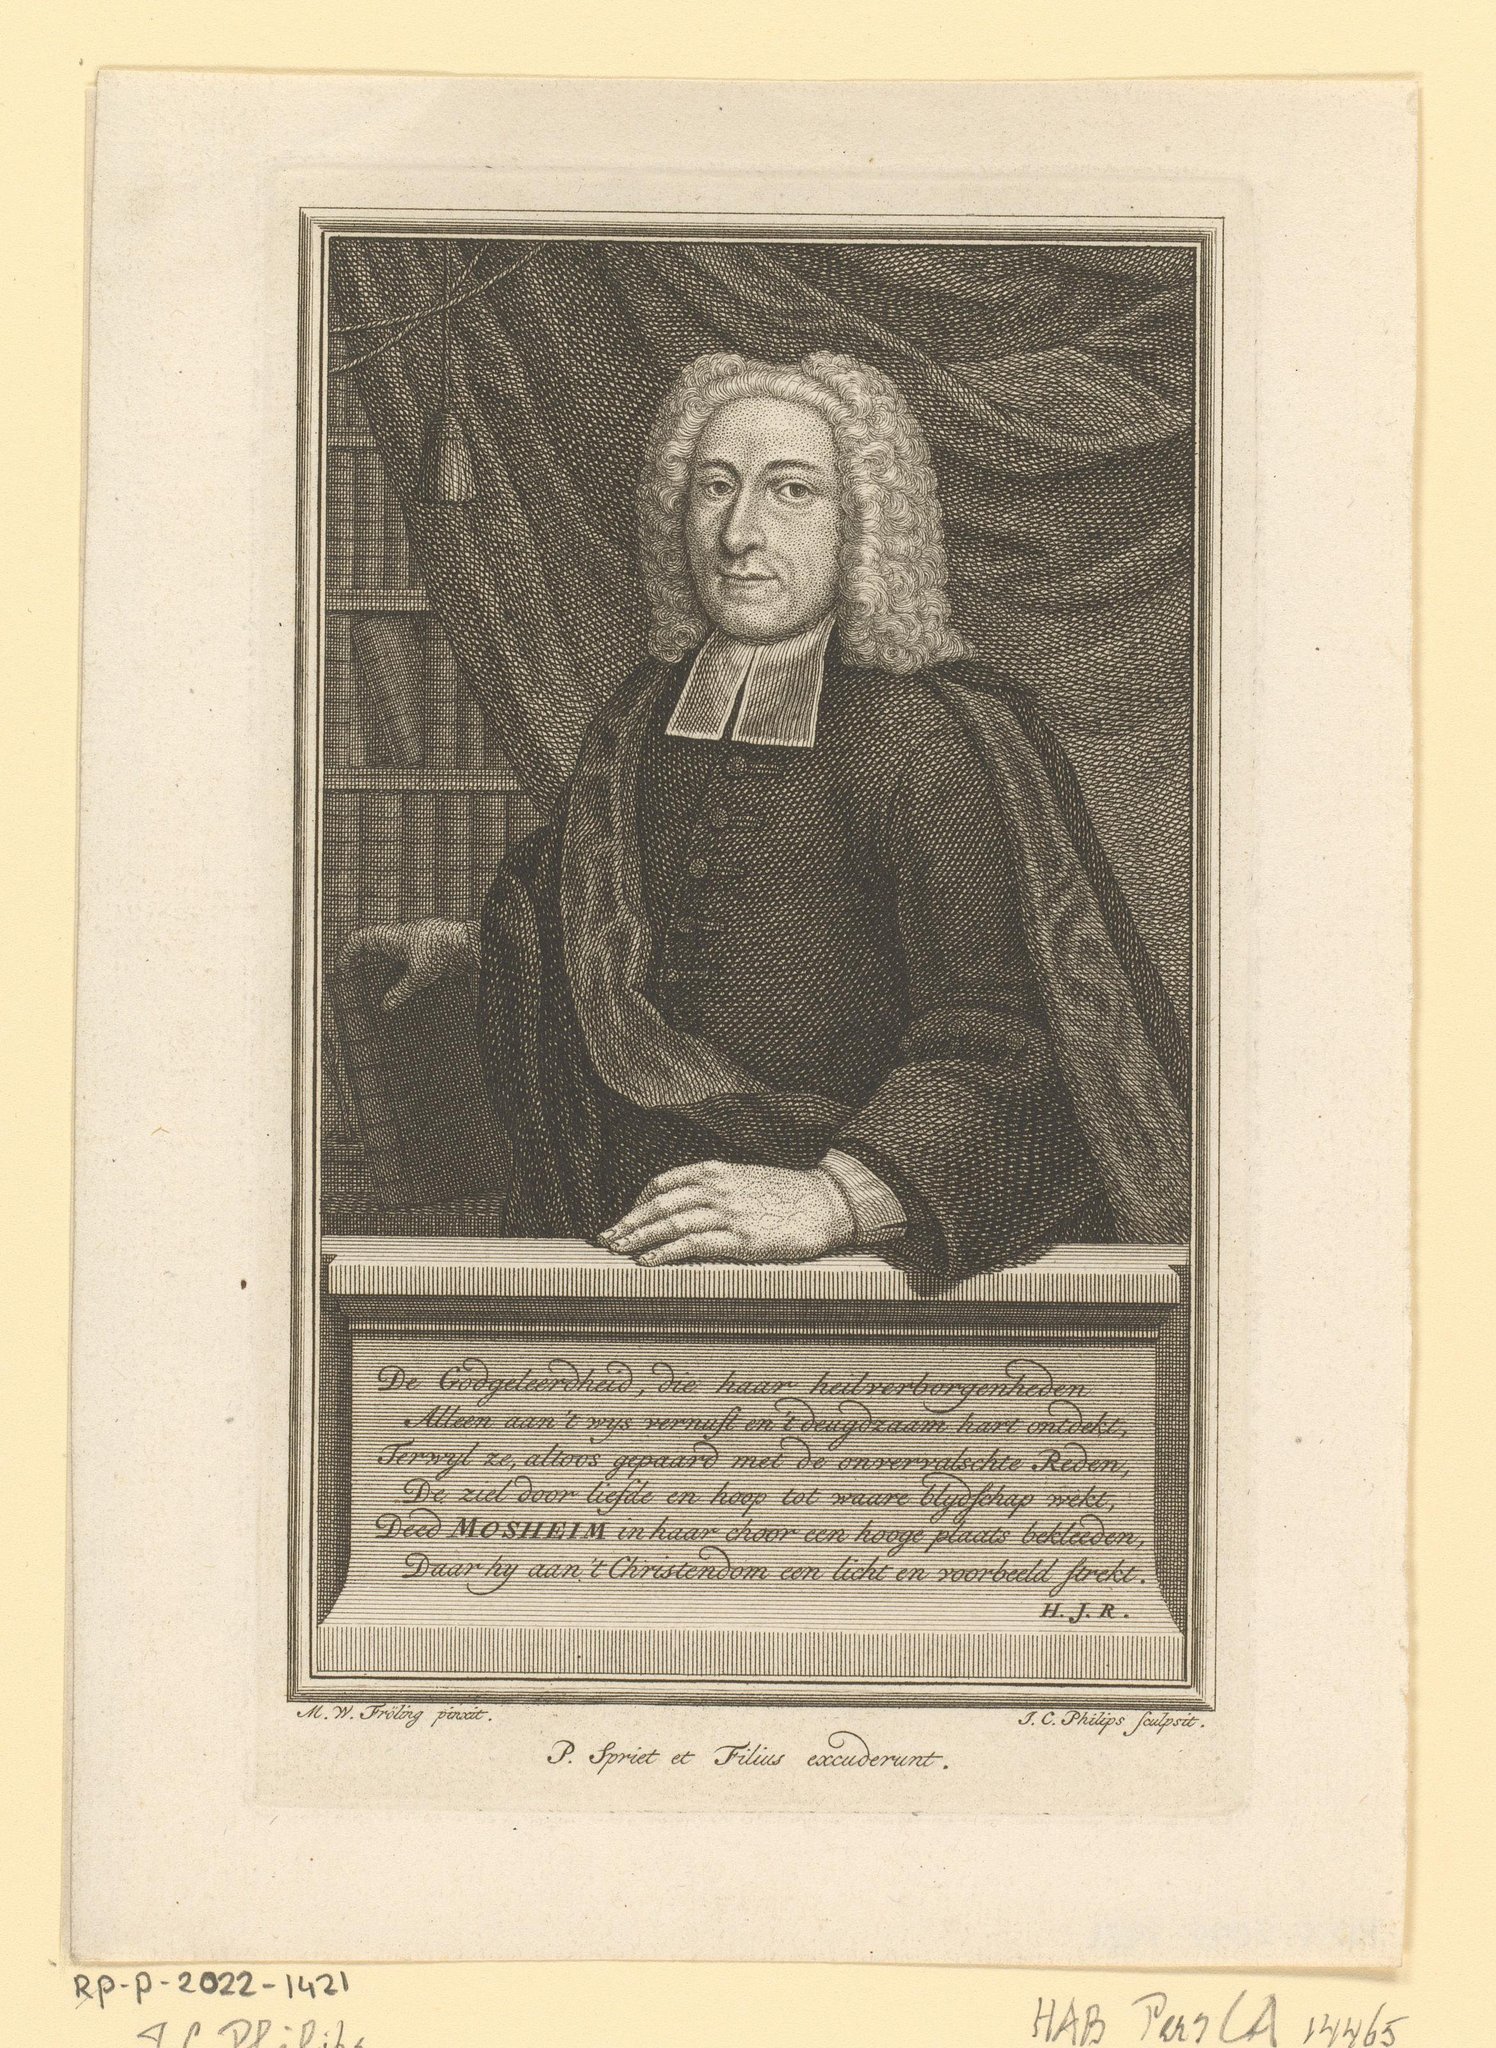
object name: print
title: Portret van Johann Lorenz von Mosheim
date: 1735-1775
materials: paper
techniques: engraving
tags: quill, ink-well, historical persons, paper (writing material)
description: Met zesregelig Nederlands vers als onderschrift.